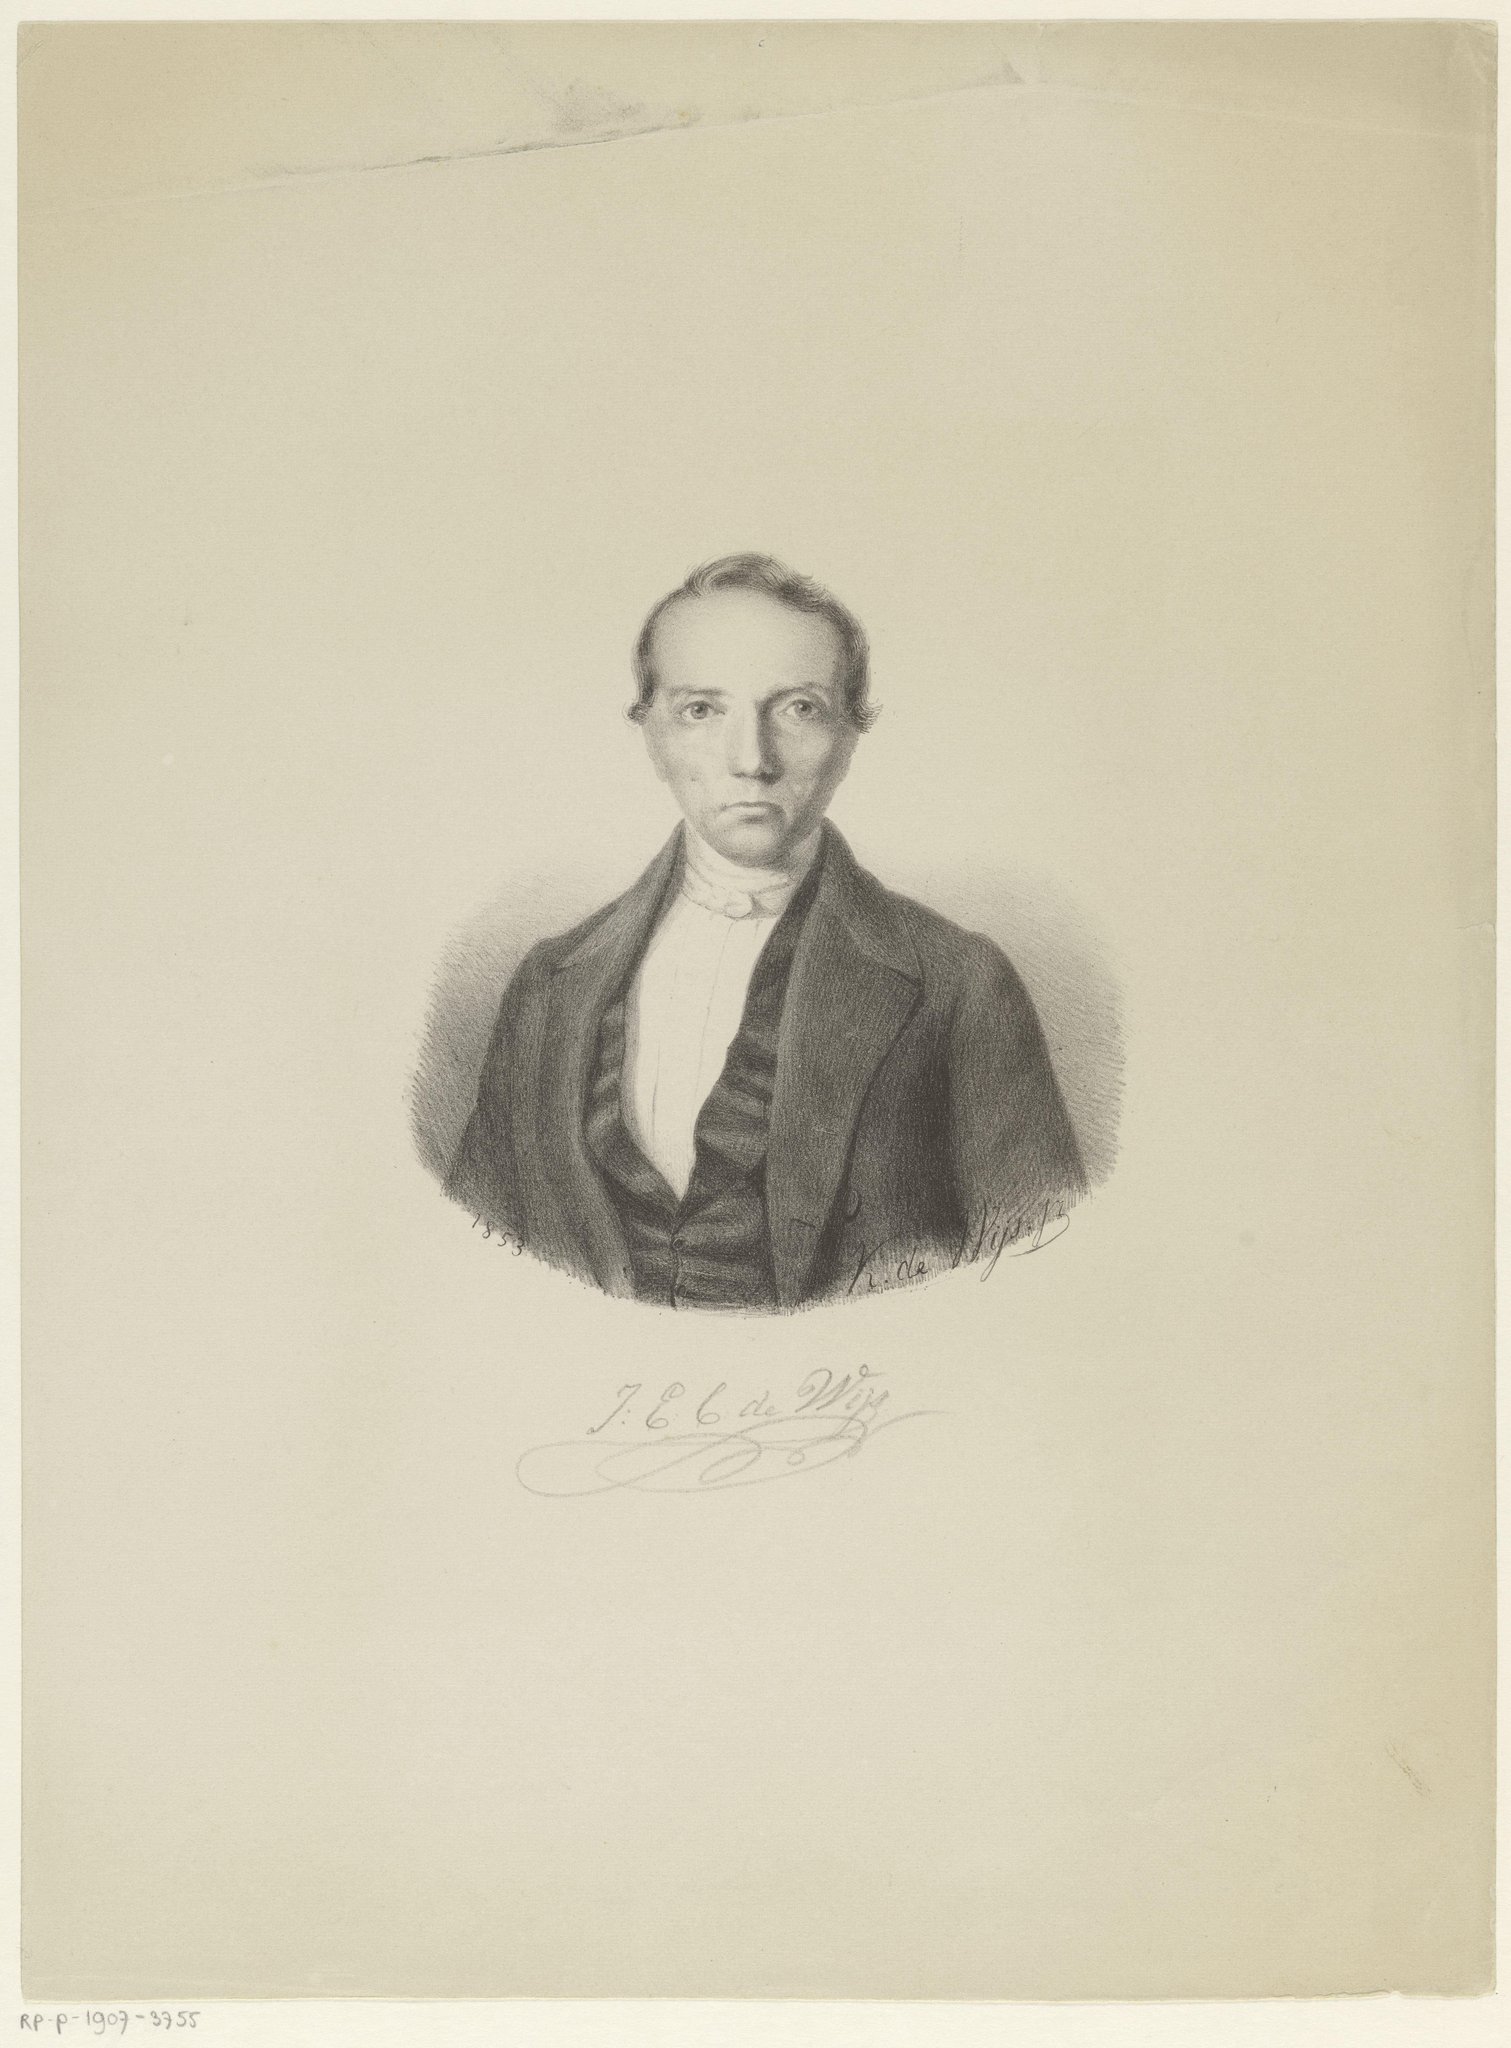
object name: print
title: Portret van Jean Esaie Christierne de Wijs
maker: kornelis jzn de wijs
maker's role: print maker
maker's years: 1832-1896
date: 1853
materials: paper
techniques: lithograph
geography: the hague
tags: historical persons (+ (full) bust portrait)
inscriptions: collector's mark: Lugt 2228